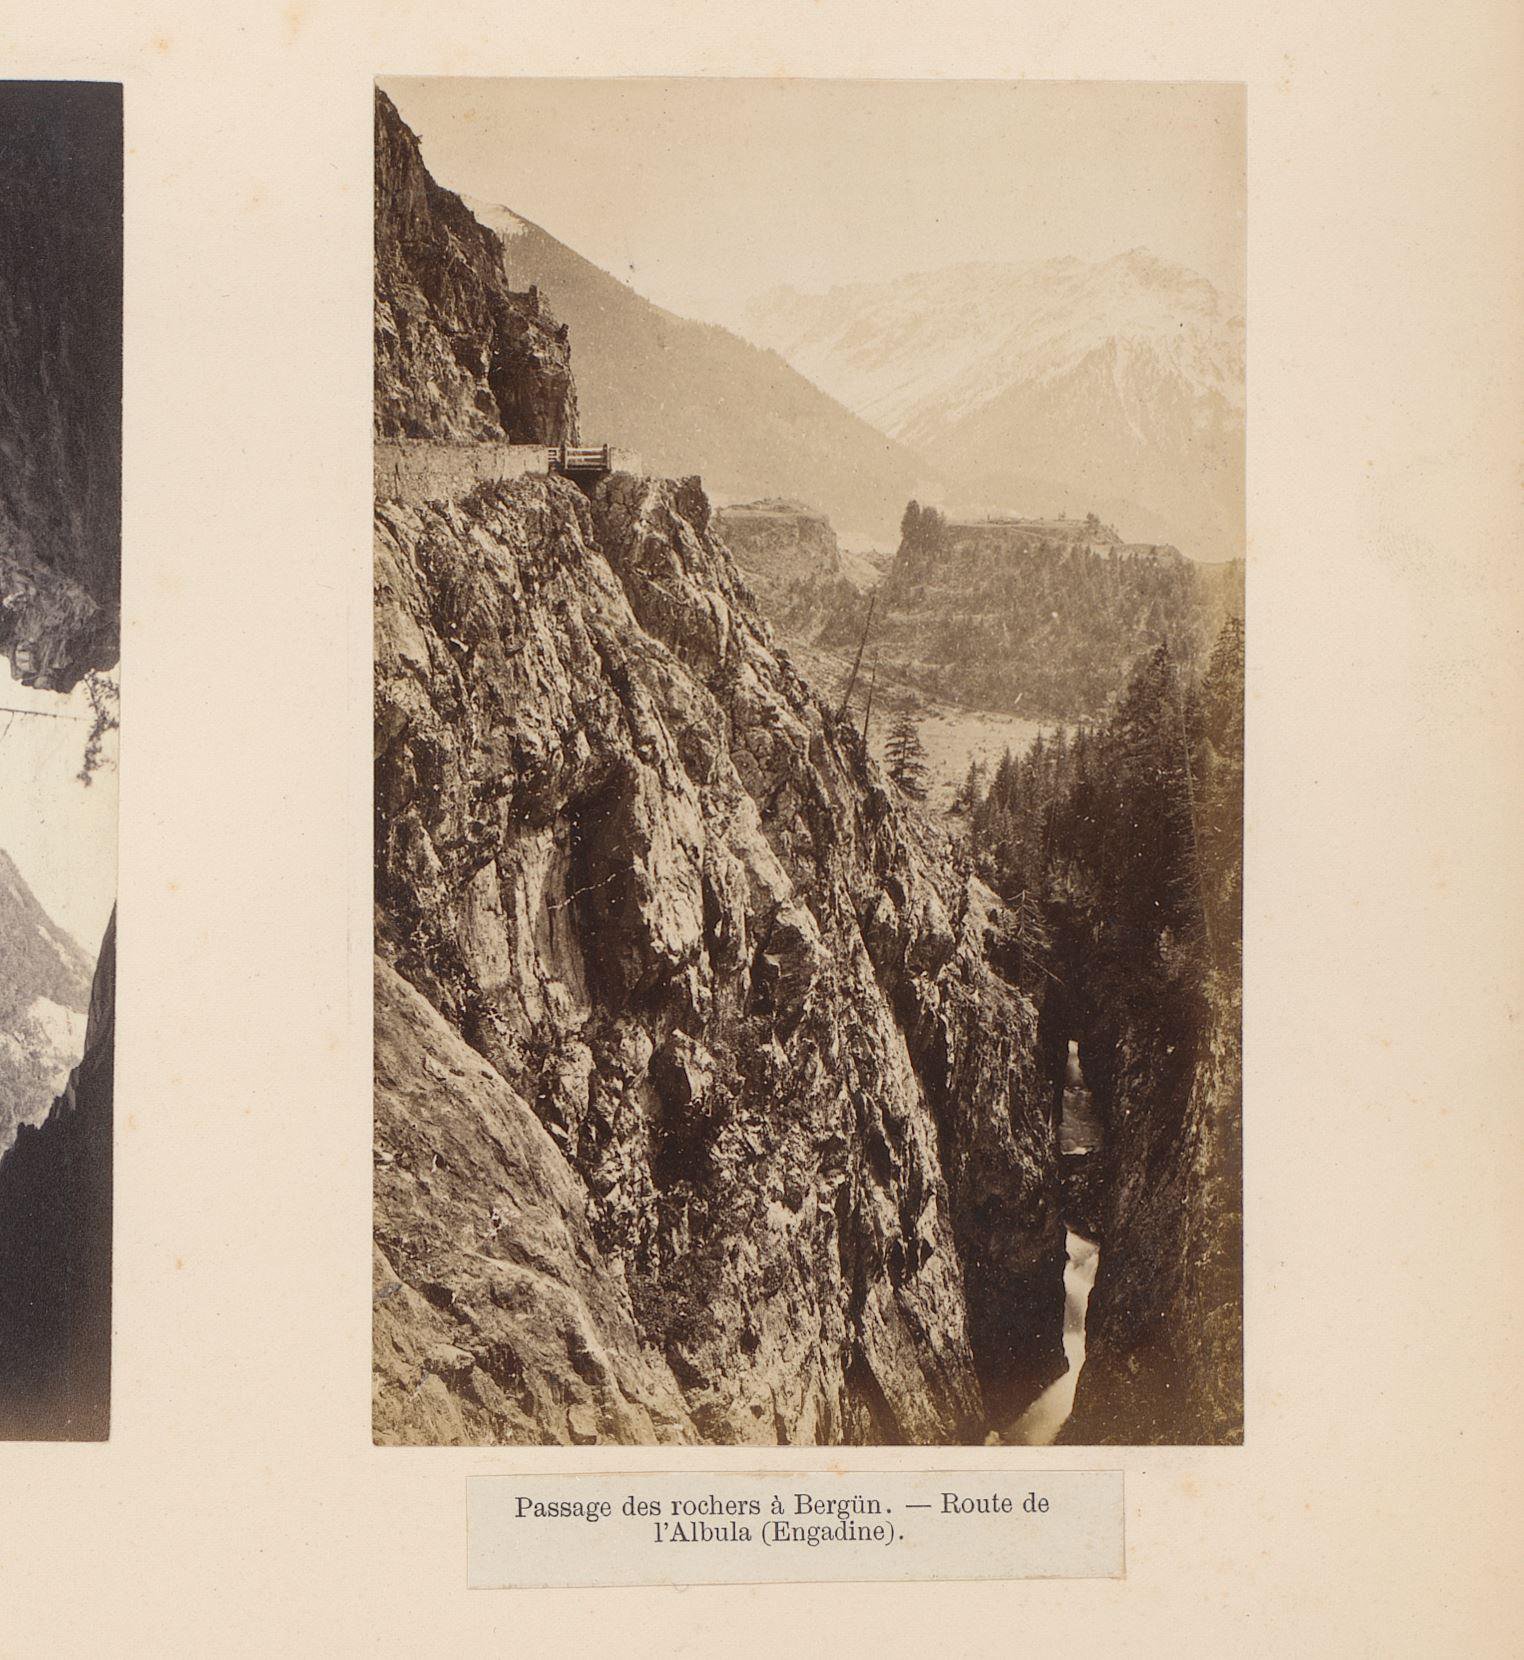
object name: photograph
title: Passage des rochers à Bergün - Route de l'Abula (Engadine)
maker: Anonymous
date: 1860-1890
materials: paper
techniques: albumen print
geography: bergün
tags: ravine, chasm, abyss, canyon